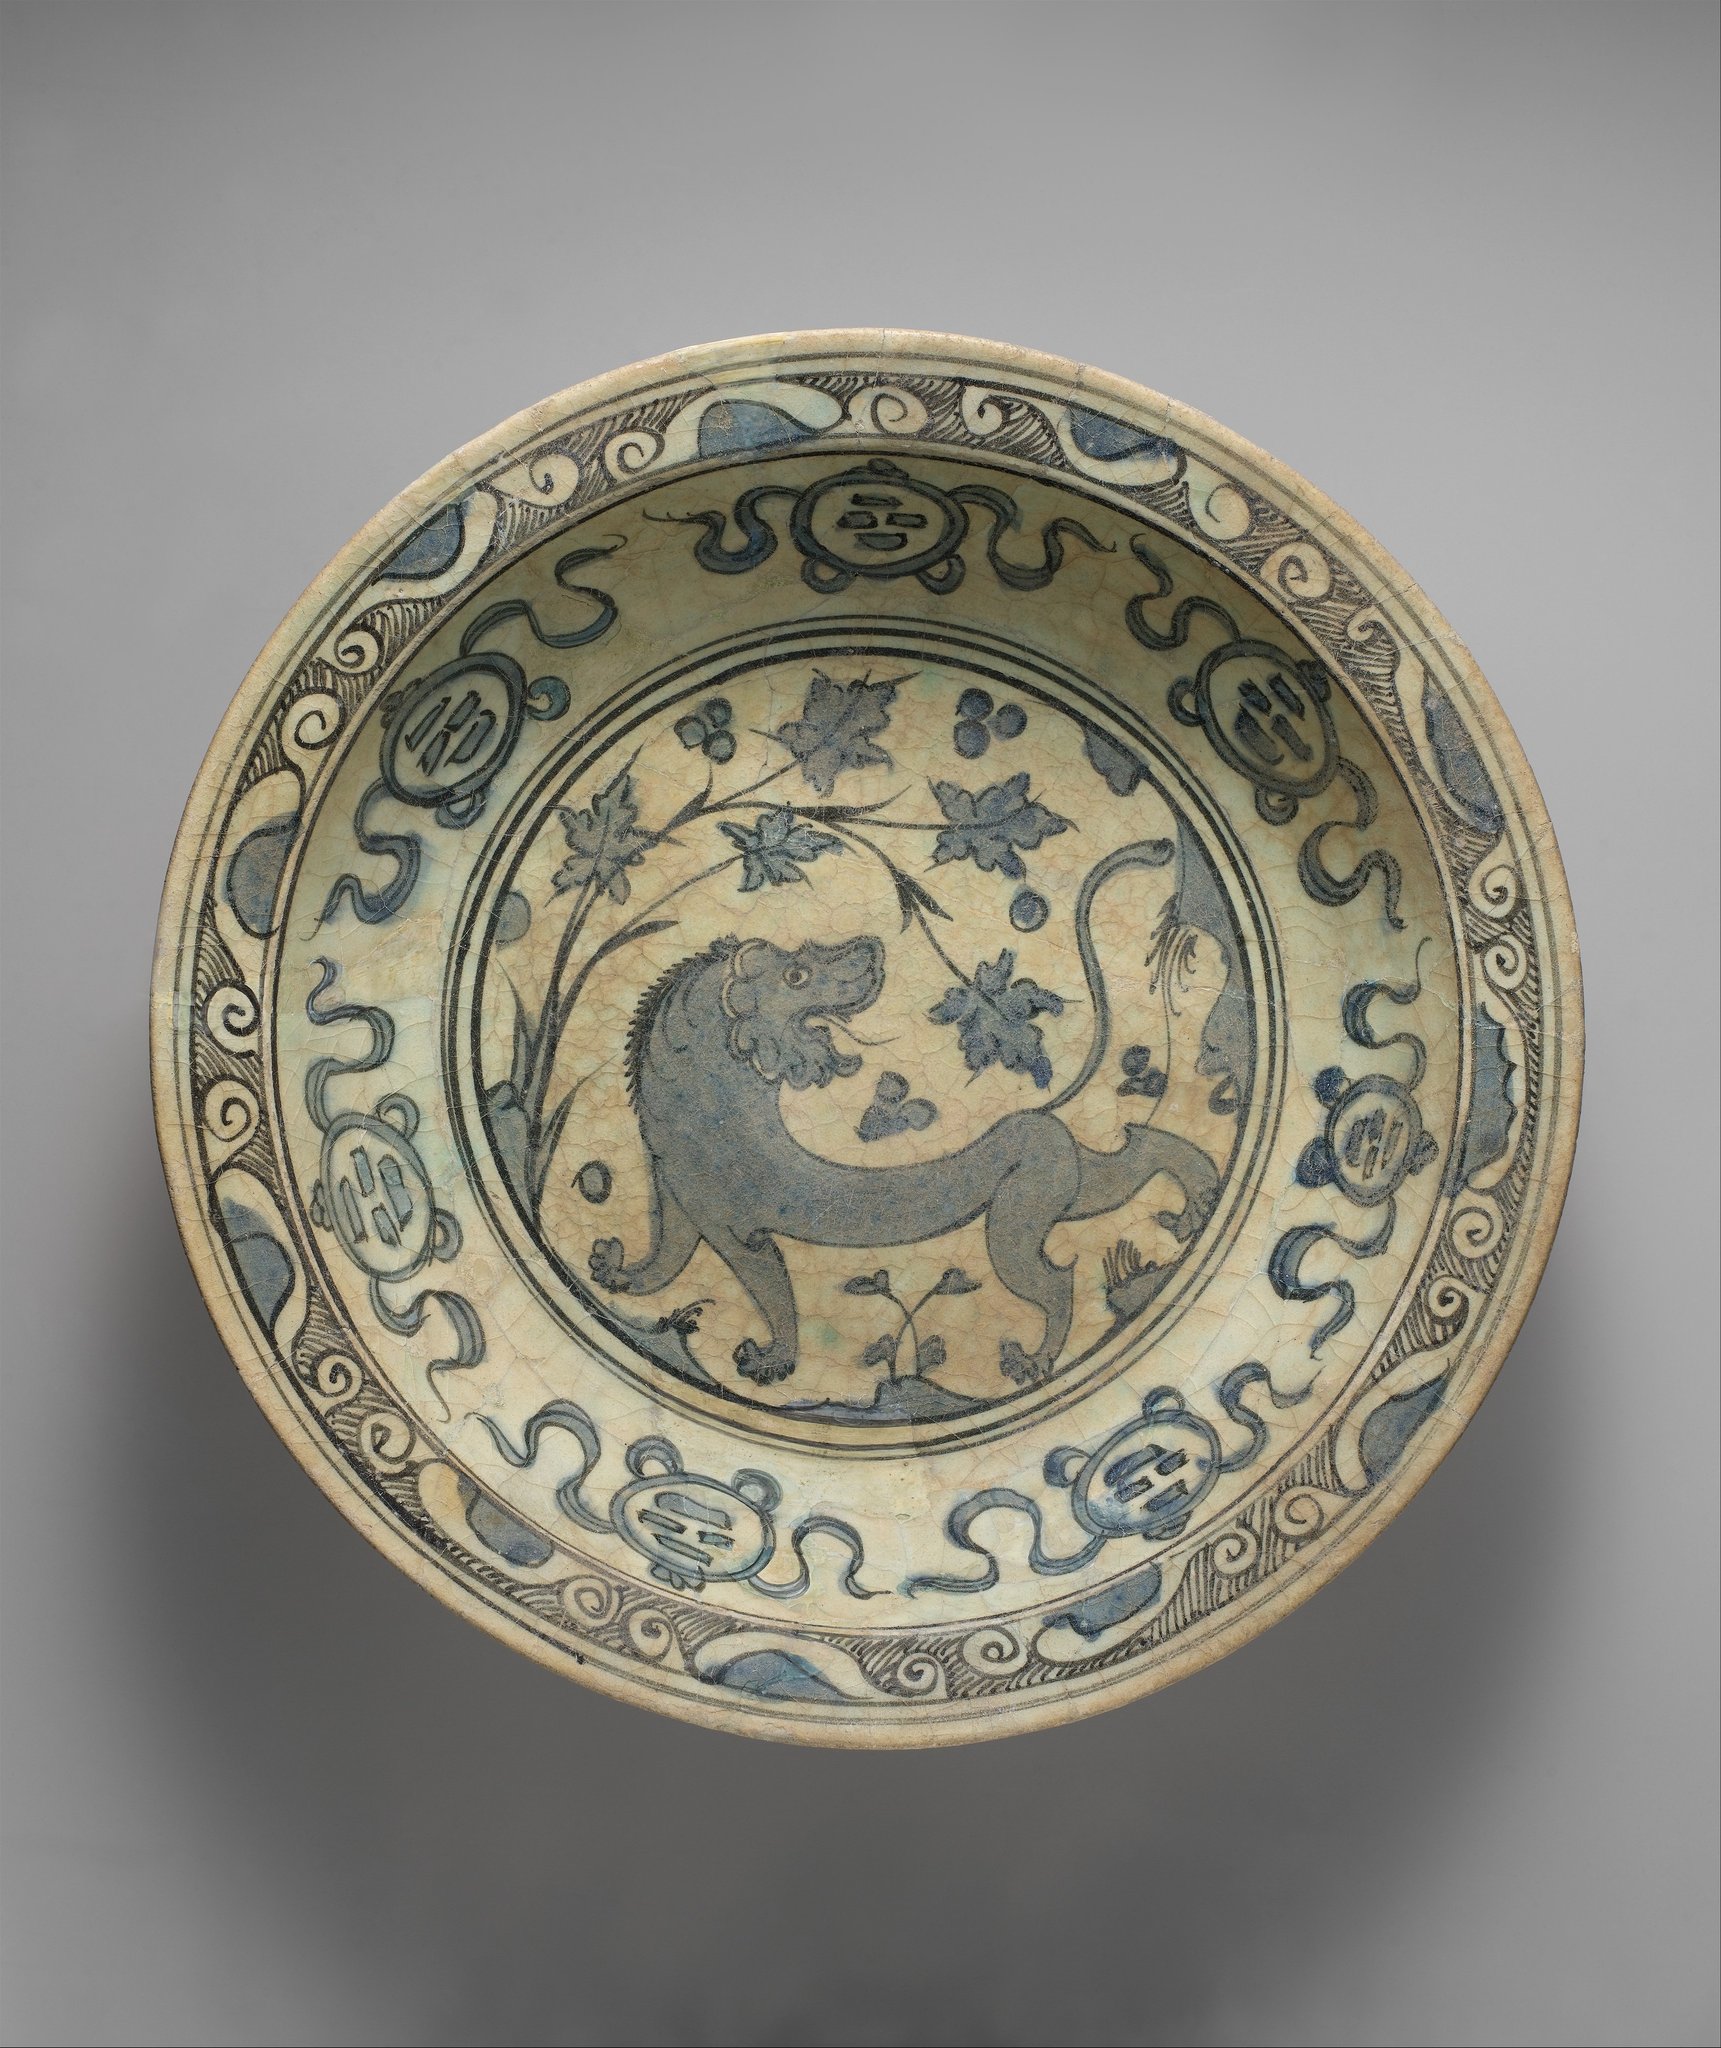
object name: bowl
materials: stonepaste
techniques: painting, underglaze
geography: iran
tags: lions